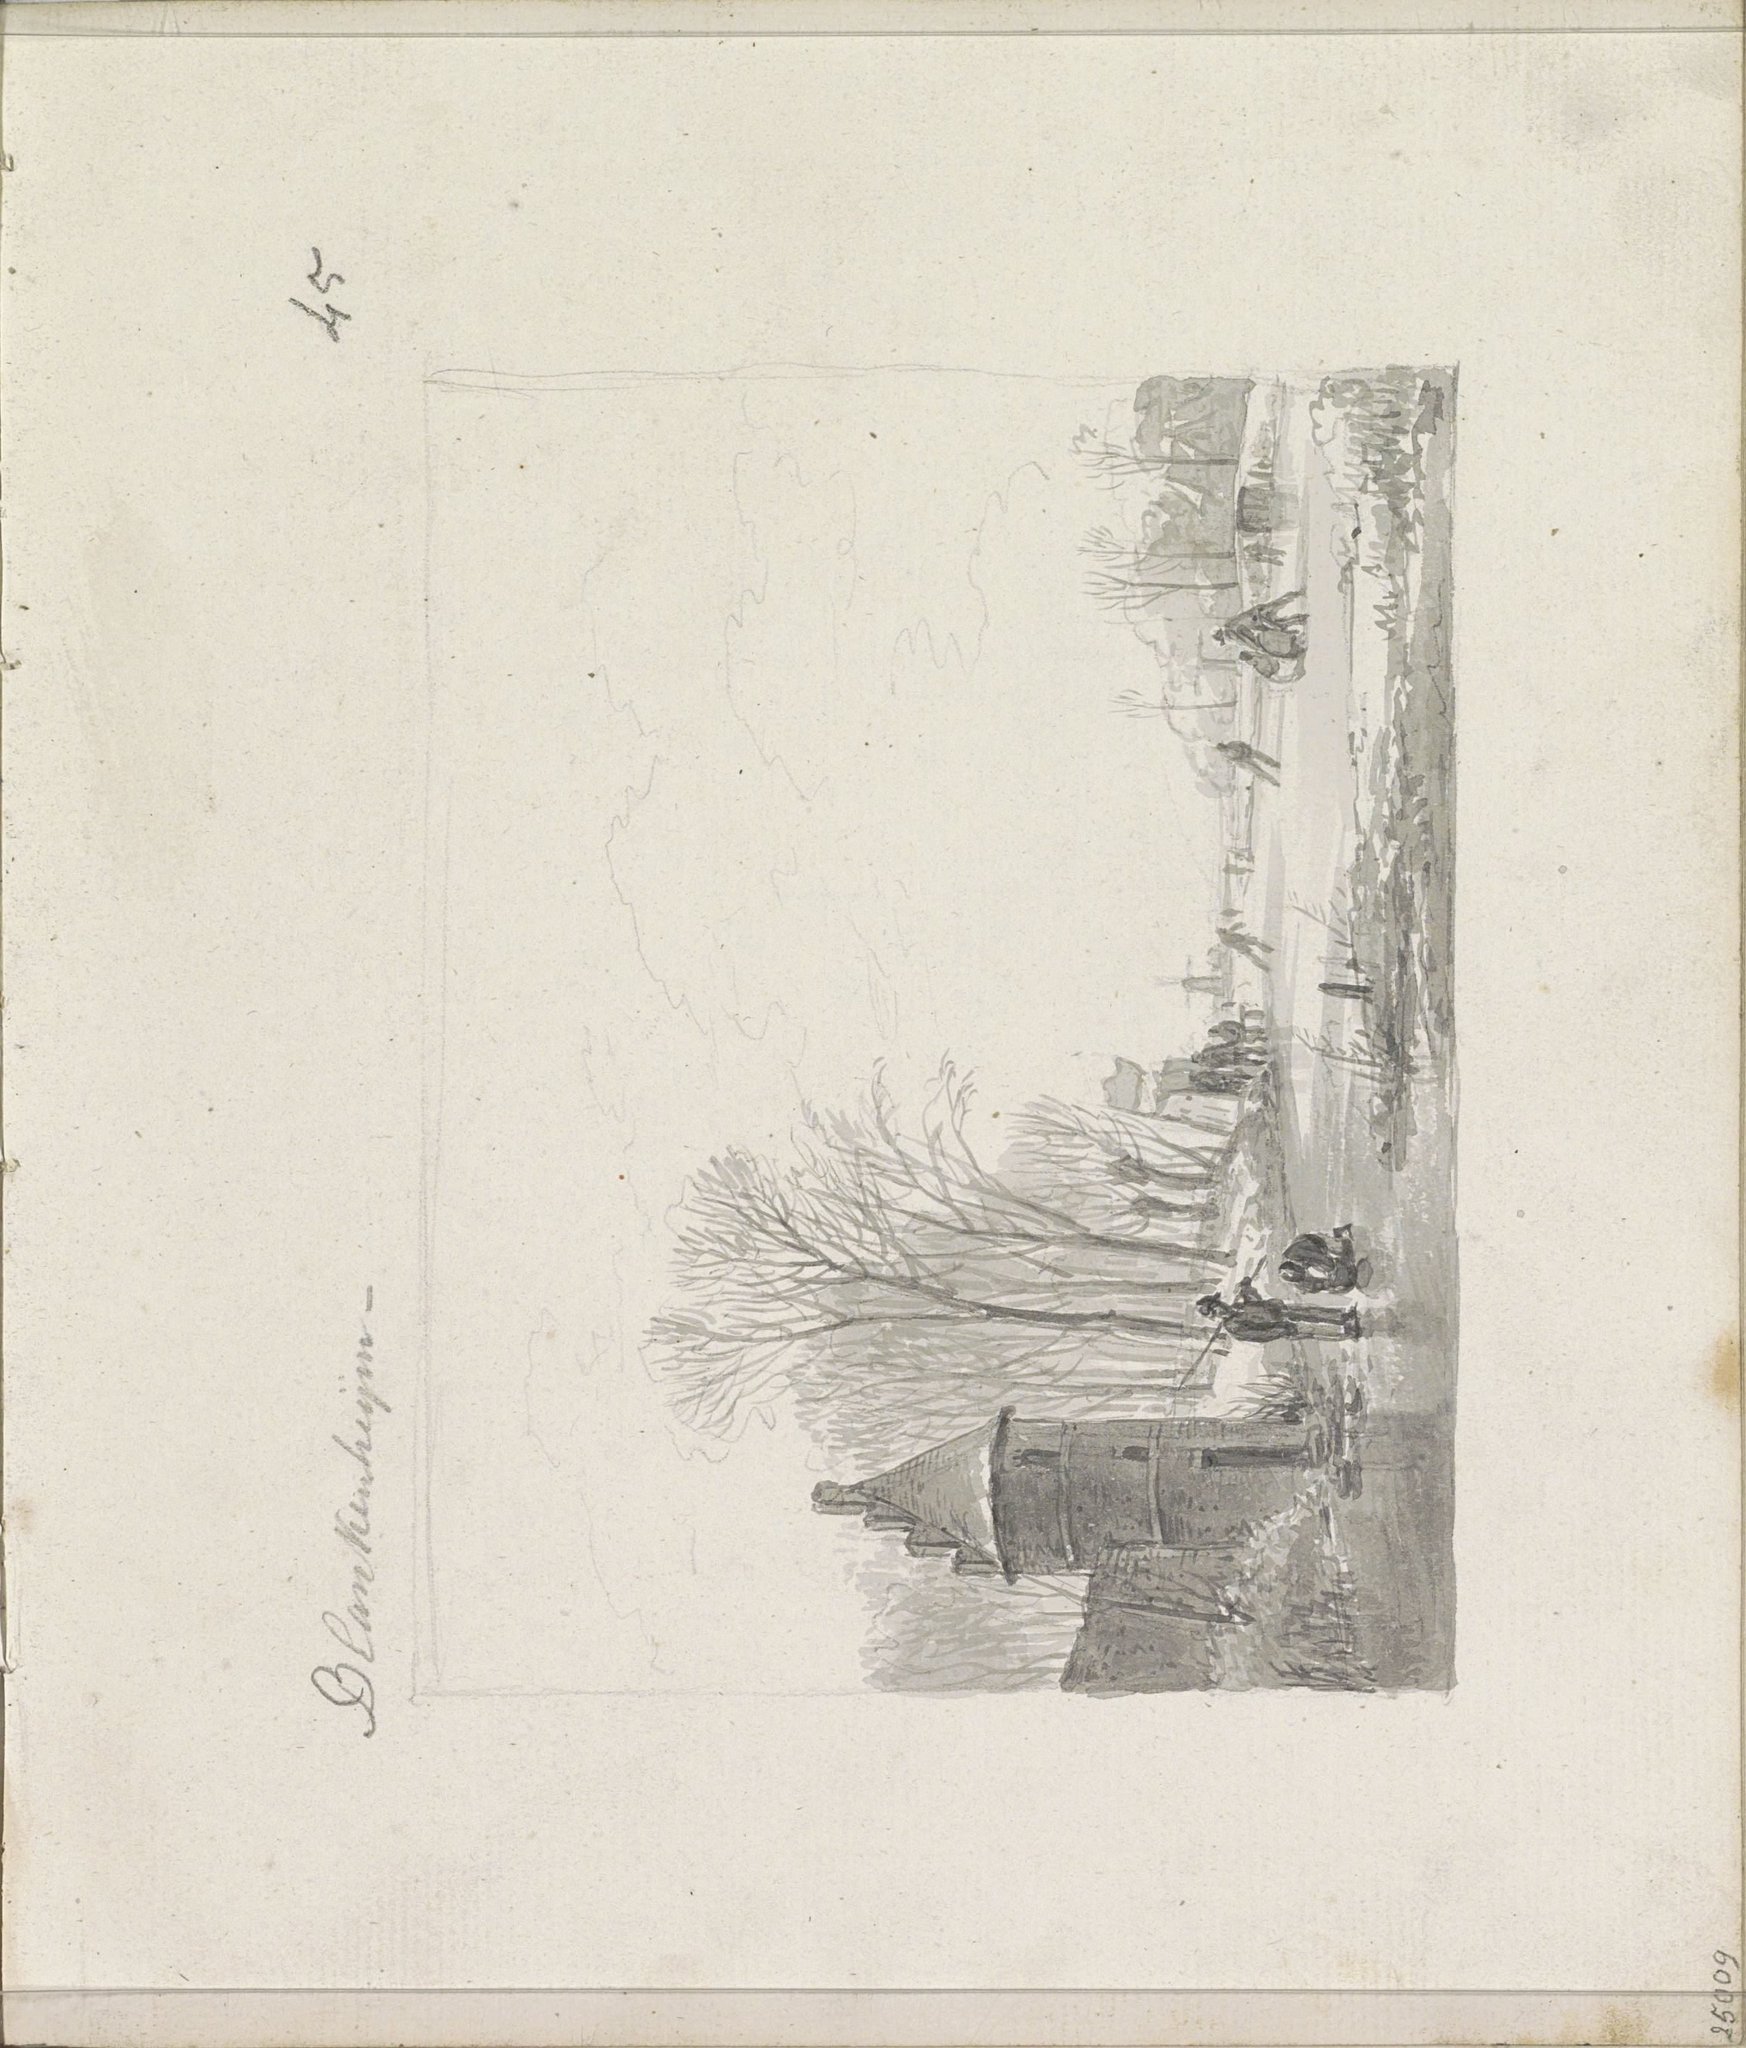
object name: sketchbook leaf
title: Winterlandschap met schaatsers en een koek-en-zopie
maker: andreas schelfhout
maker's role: draughtsman, painter, print maker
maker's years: 1787-1870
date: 1825-1829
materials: paper, pencil, watercolor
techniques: brush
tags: frost, freezing weather, skates (winter sports)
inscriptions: number: ‘45/ 25009’, annotation: ‘Blankenheijm-’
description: Langs de bevroren vaart staat een toren. Op de achtergrond een molen. Blad 59 recto uit een schetsboek met 95 bladen.